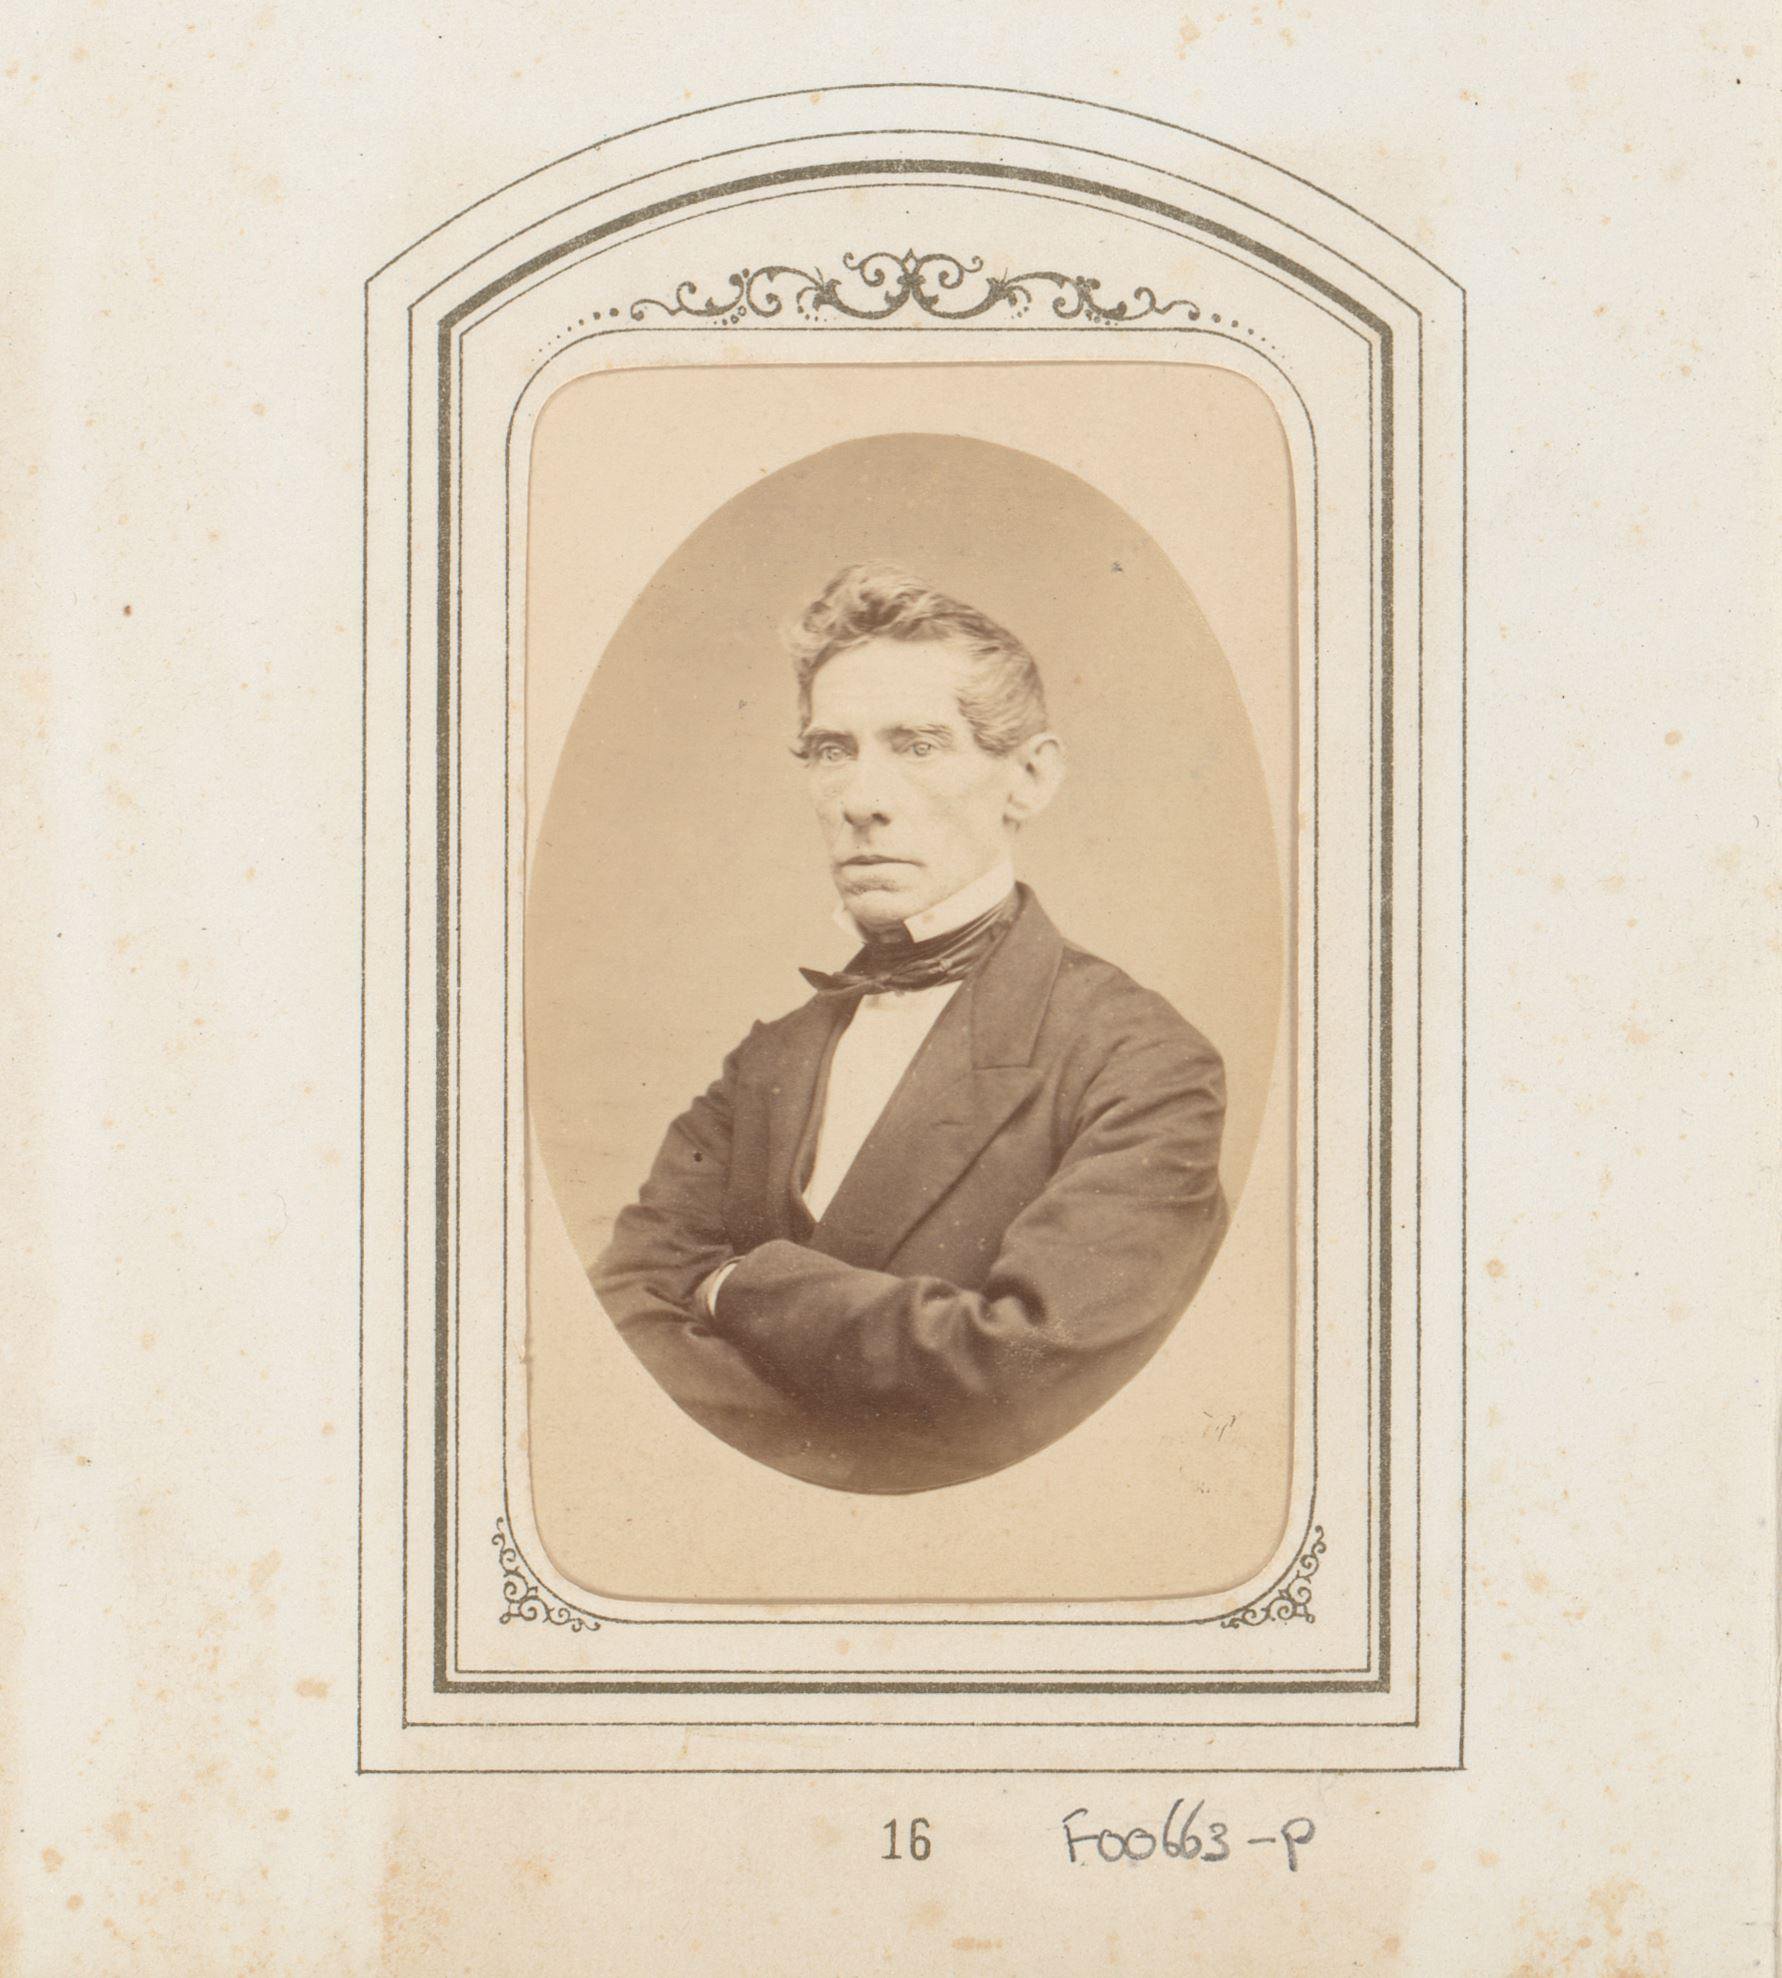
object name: album leaf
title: Portret van een man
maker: hendrik anthonie karel ringler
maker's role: draughtsman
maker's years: 1846-1879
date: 1860-1880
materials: cardboard, photographic support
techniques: albumen print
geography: leeuwarden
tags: historical persons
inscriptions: number: ‘16’, inscription: ‘Photographisch/ Atelier van H.A.K. Ringler/ Nieuwe Weststraat tegenover het Station/ Leeuwarden (...)’